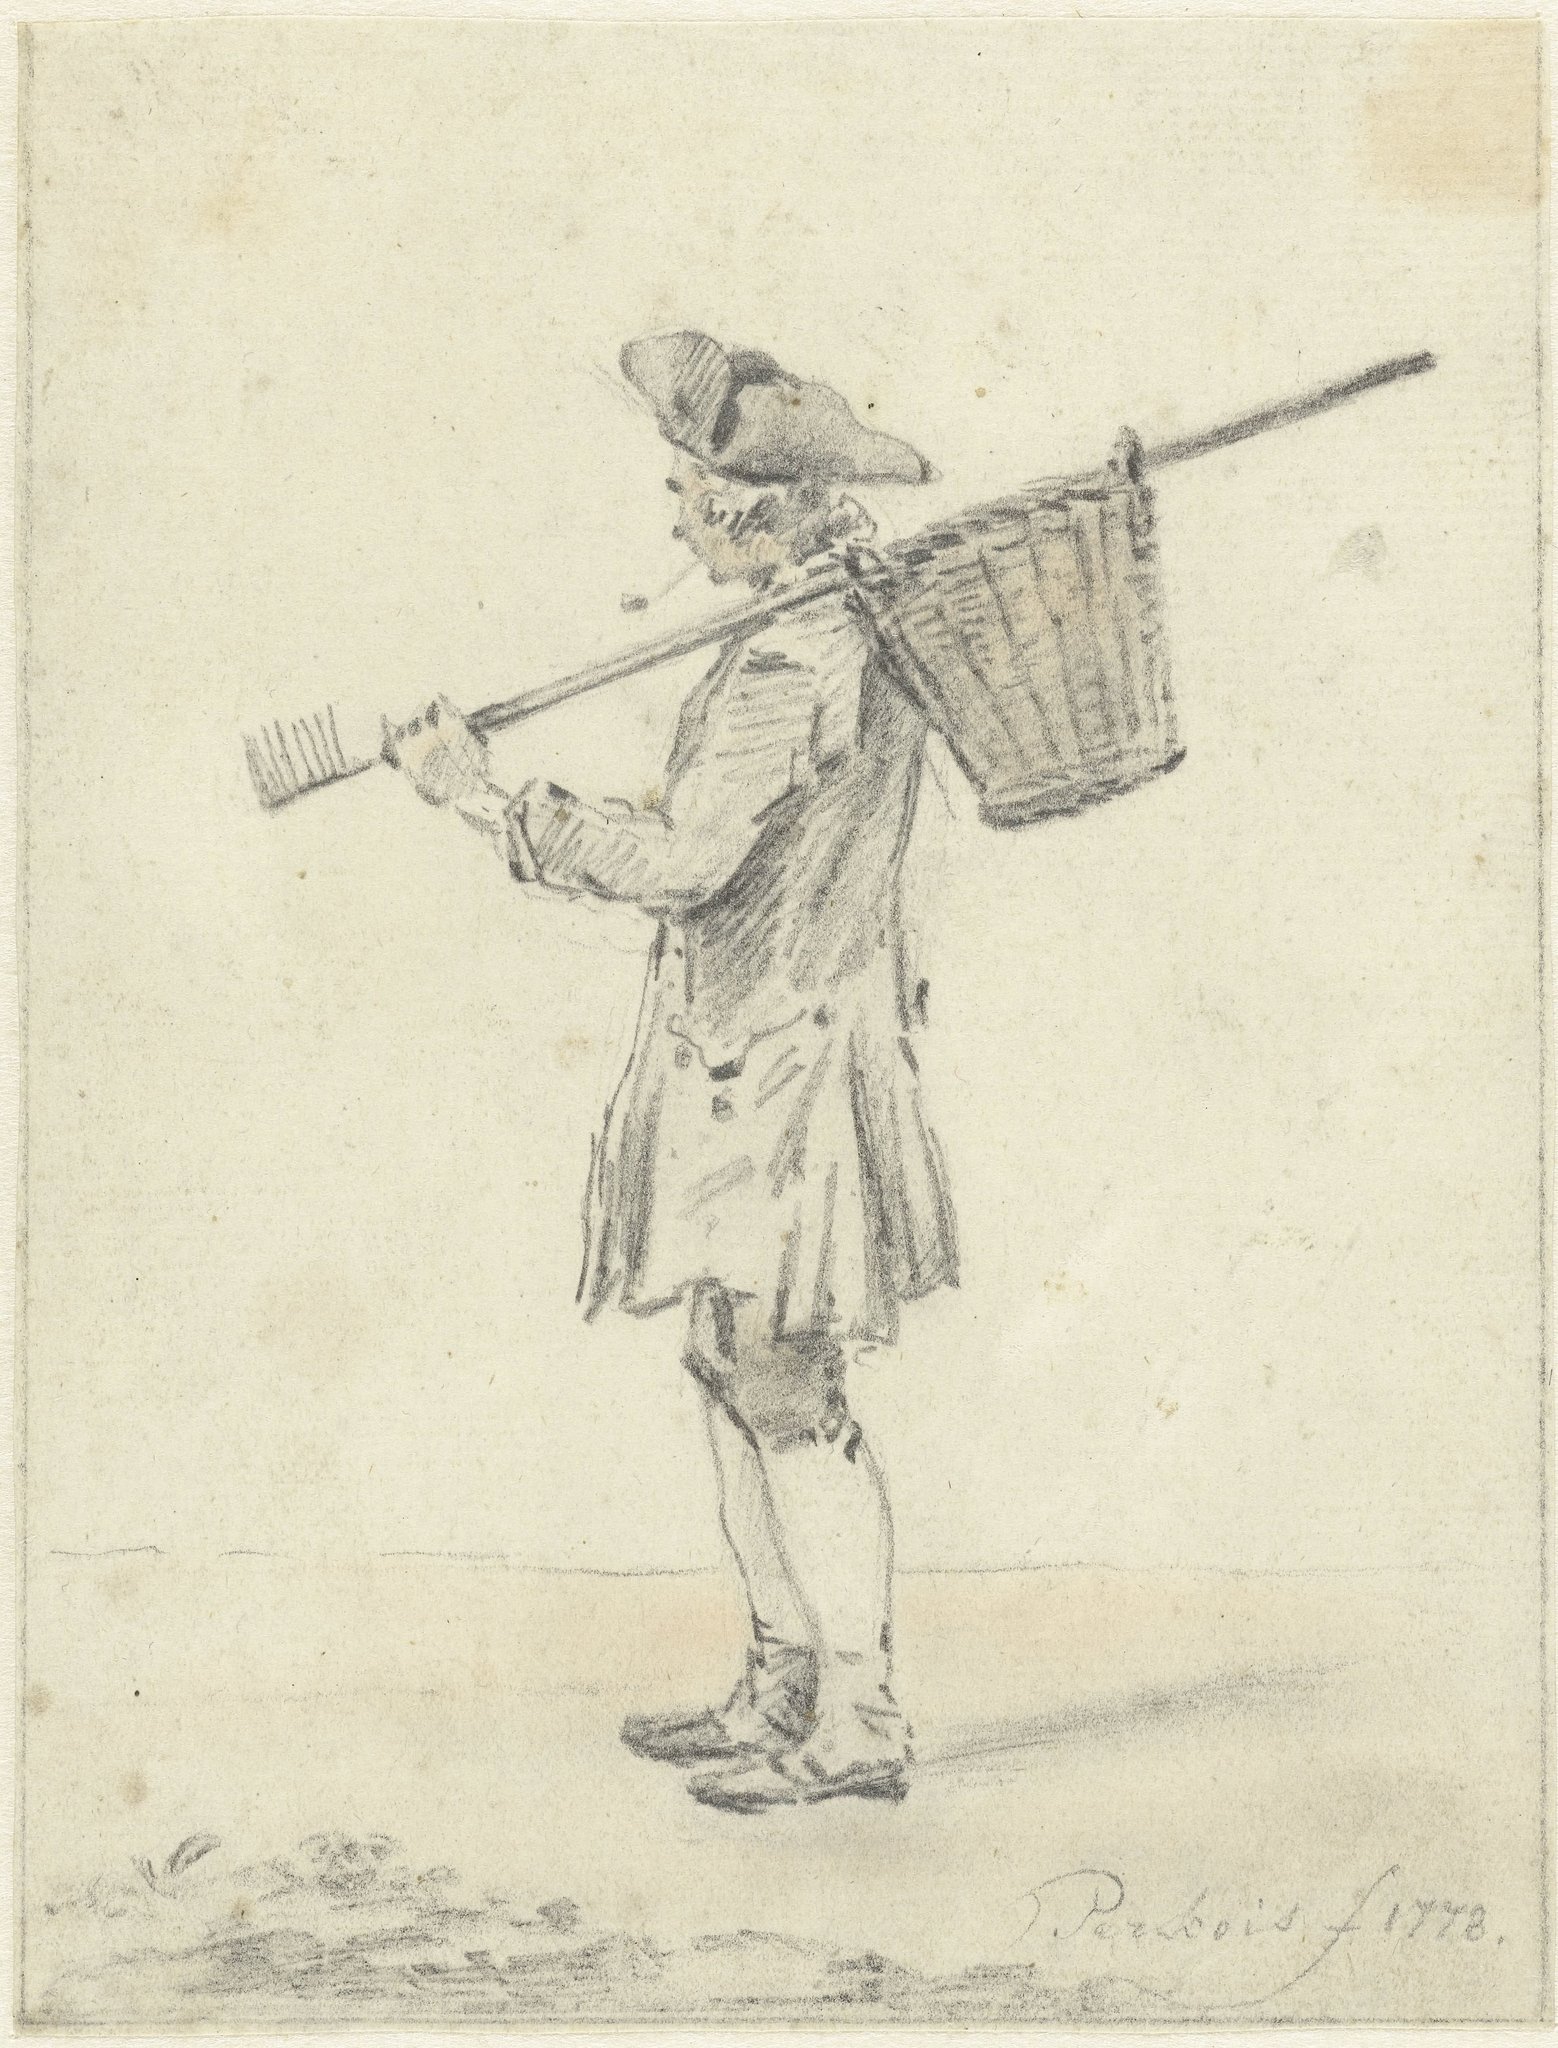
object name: drawing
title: Staande man met een hark over de schouder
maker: jacob perkois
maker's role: draughtsman, print maker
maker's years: 1756-1804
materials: paper, pencil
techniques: brush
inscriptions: date: ‘1778’, date: ‘1777 9m/11d’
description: Staande man met een hark over de schouder waaraan een mand hangt.